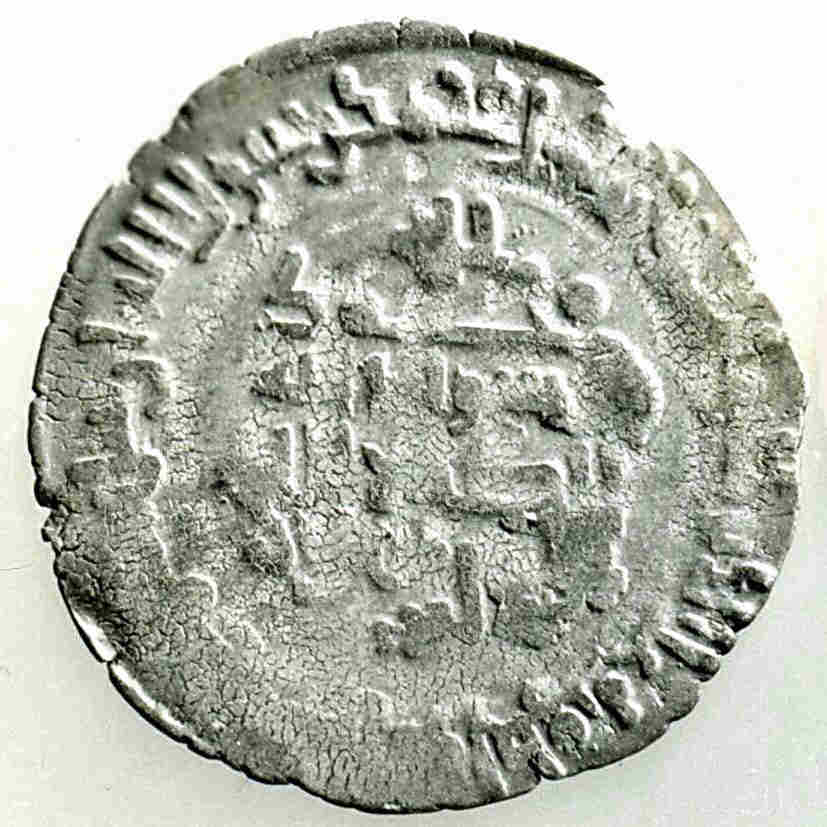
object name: coin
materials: silver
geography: al-shash